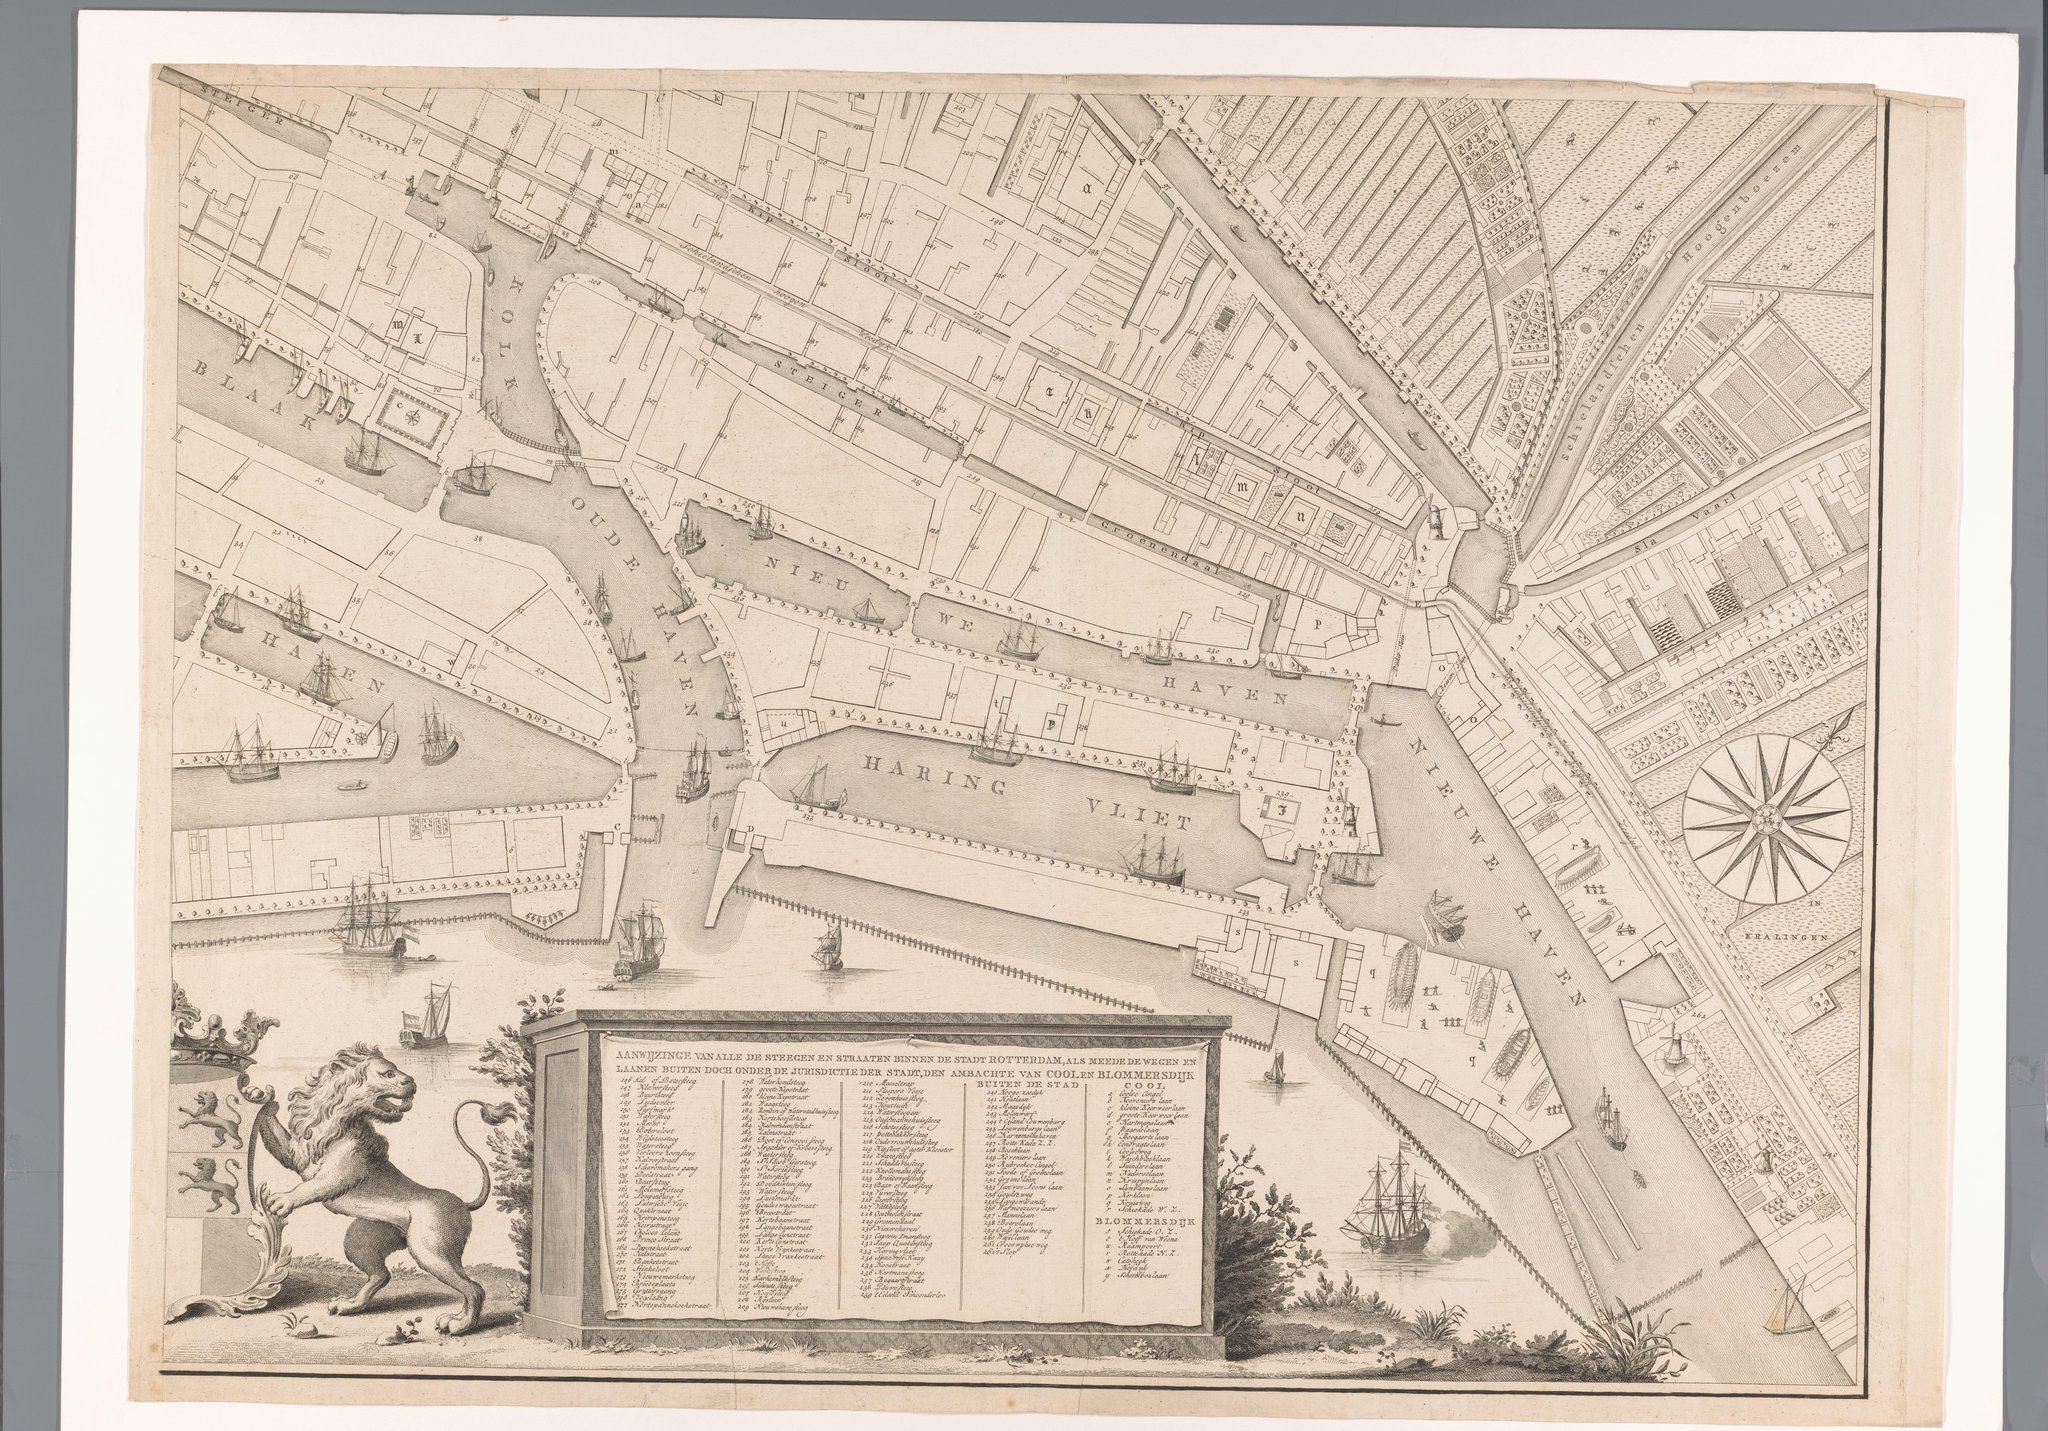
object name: area plan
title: Plattegrond van Rotterdam (deel rechtsonder)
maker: cornelis van baarsel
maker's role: print maker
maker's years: 1761-1826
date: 1800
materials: paper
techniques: engraving, etching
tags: coat of arms (as symbol of the state, etc.) (+ city; municipal), maps of separate countries or regions, rotterdam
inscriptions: collector's mark: Lugt 2233